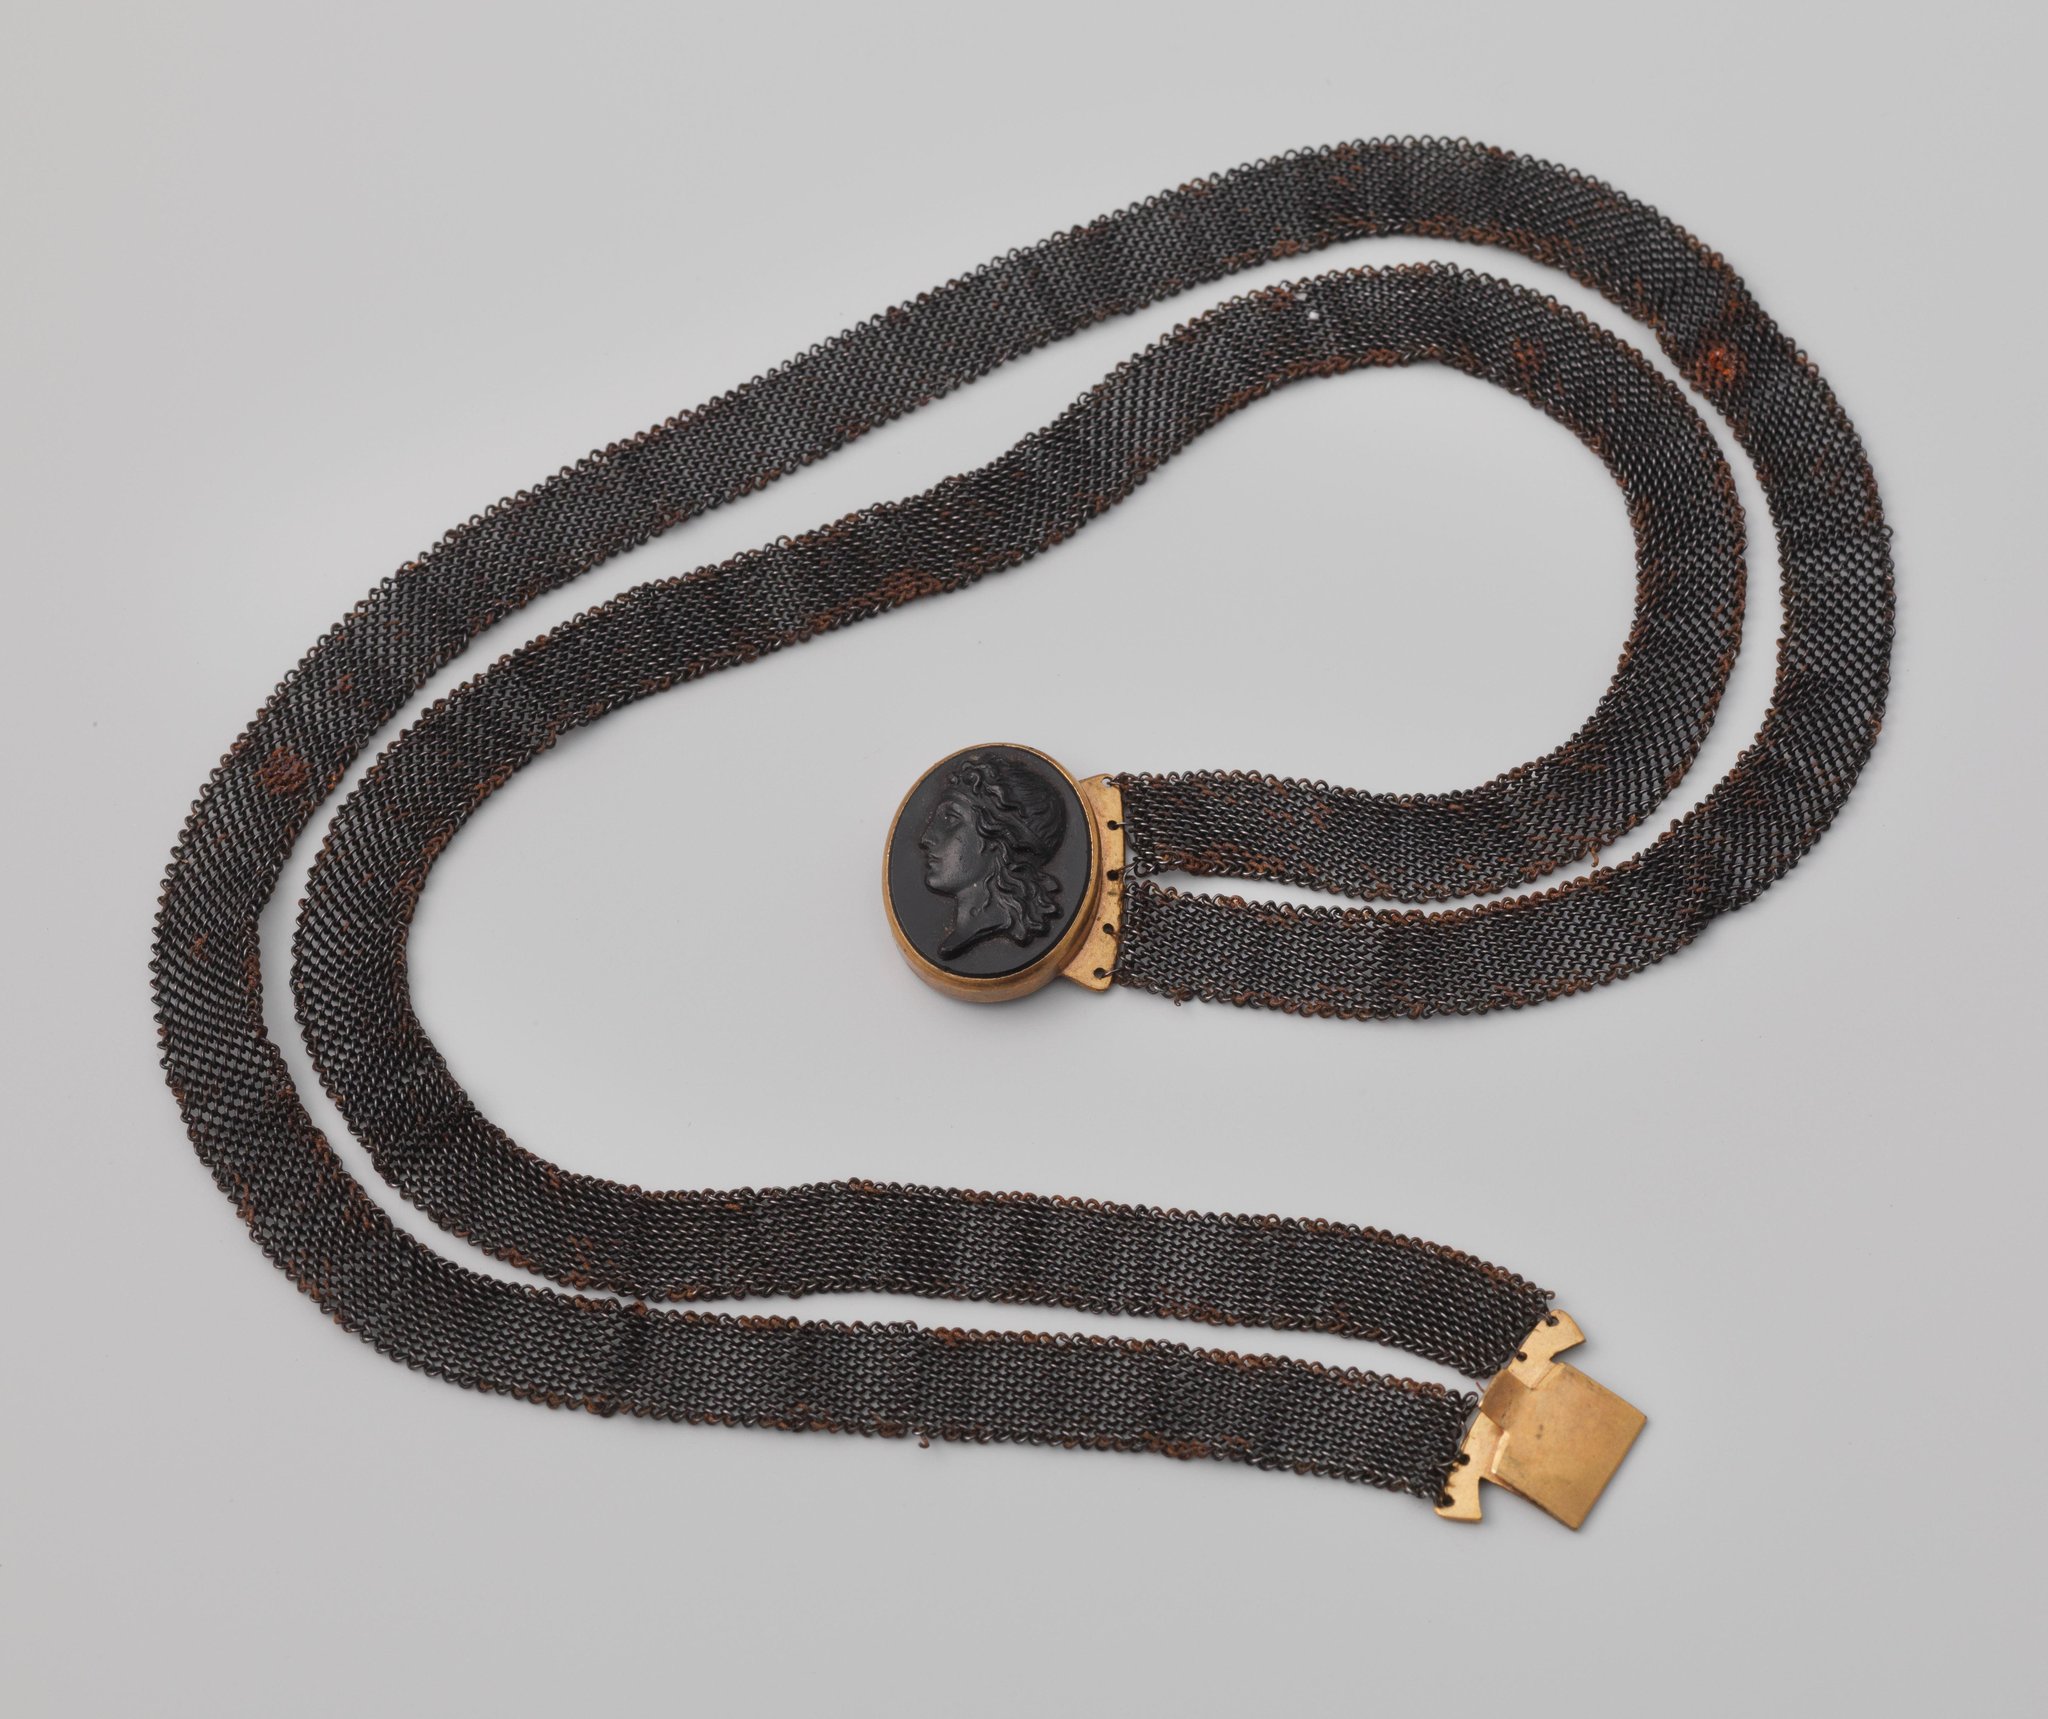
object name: jewellery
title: Halsketting van gevlochten gelakt ijzer met camee in gouden slot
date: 1815-1830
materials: gold, iron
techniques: lacquer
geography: great britain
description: Halsketting van zwart geverfd ijzer met een zwarte camee in een gouden slot. Aan het ovale slot zijn twee banden bevestigd die nauw om de hals sluiten en van extreem fijne, in elkaar grijpende maliën zijn gemaakt. Op de camee een klassieke jongelingenkop met een hoofdband om de lange krullen.